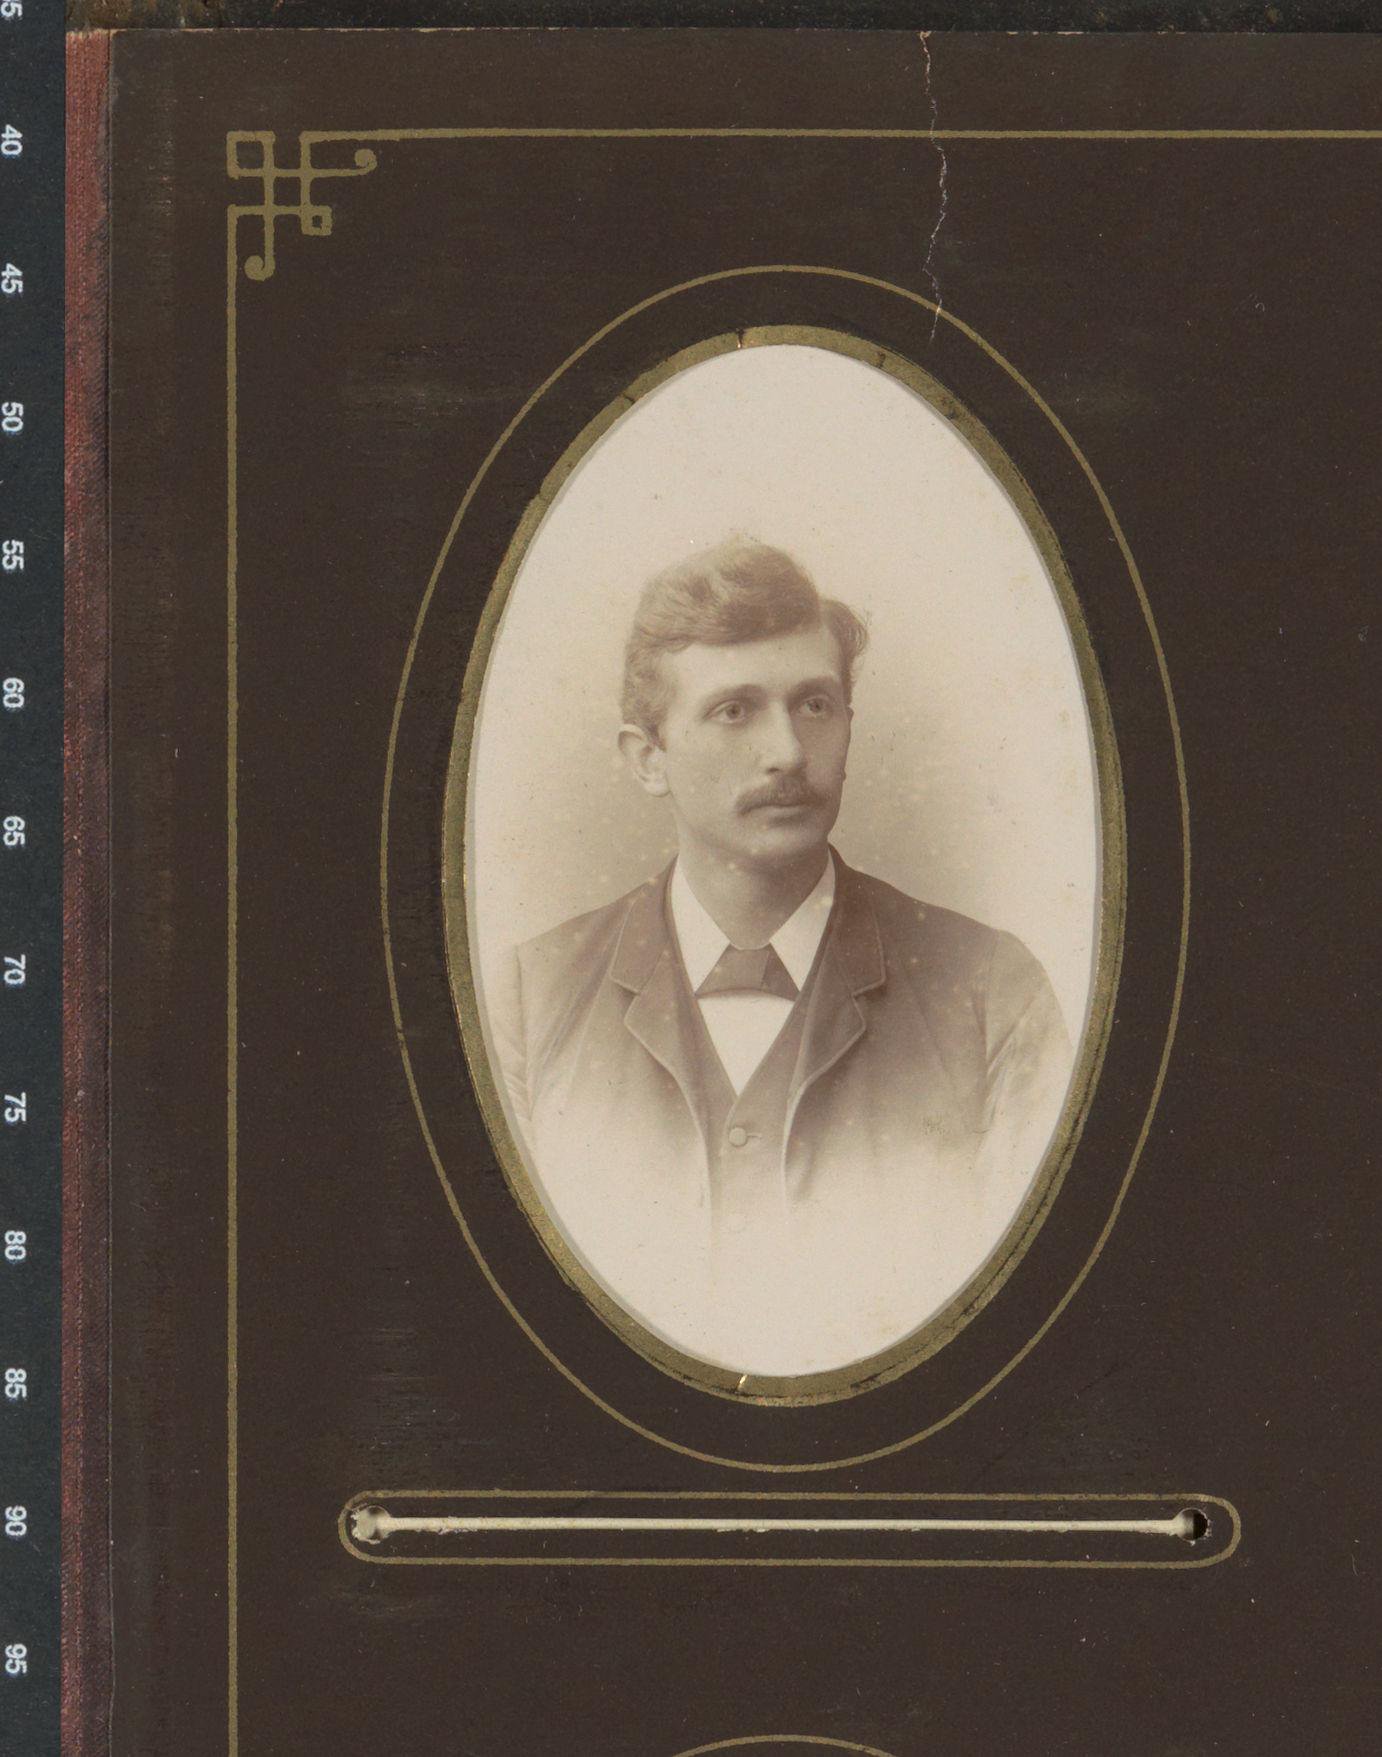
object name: photograph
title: Portret van een man met een snor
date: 1888-1892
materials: cardboard, paper, photographic support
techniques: albumen print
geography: amsterdam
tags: moustache, adult man, historical persons not known by name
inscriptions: address: ‘Amsterdam Damstraat 23 en Batavia’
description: Op de achterkant van deze carte-de-visite staat vermeld 'Woodbury & Page' Amsterdam Damstraat 23 en Batavia. De Amsterdamse zaak werd van 1888 tot 1892 geleid door Felix Busenbender, een voormalige fotograaf van Woodbury & Page in Nederlands-Indië.